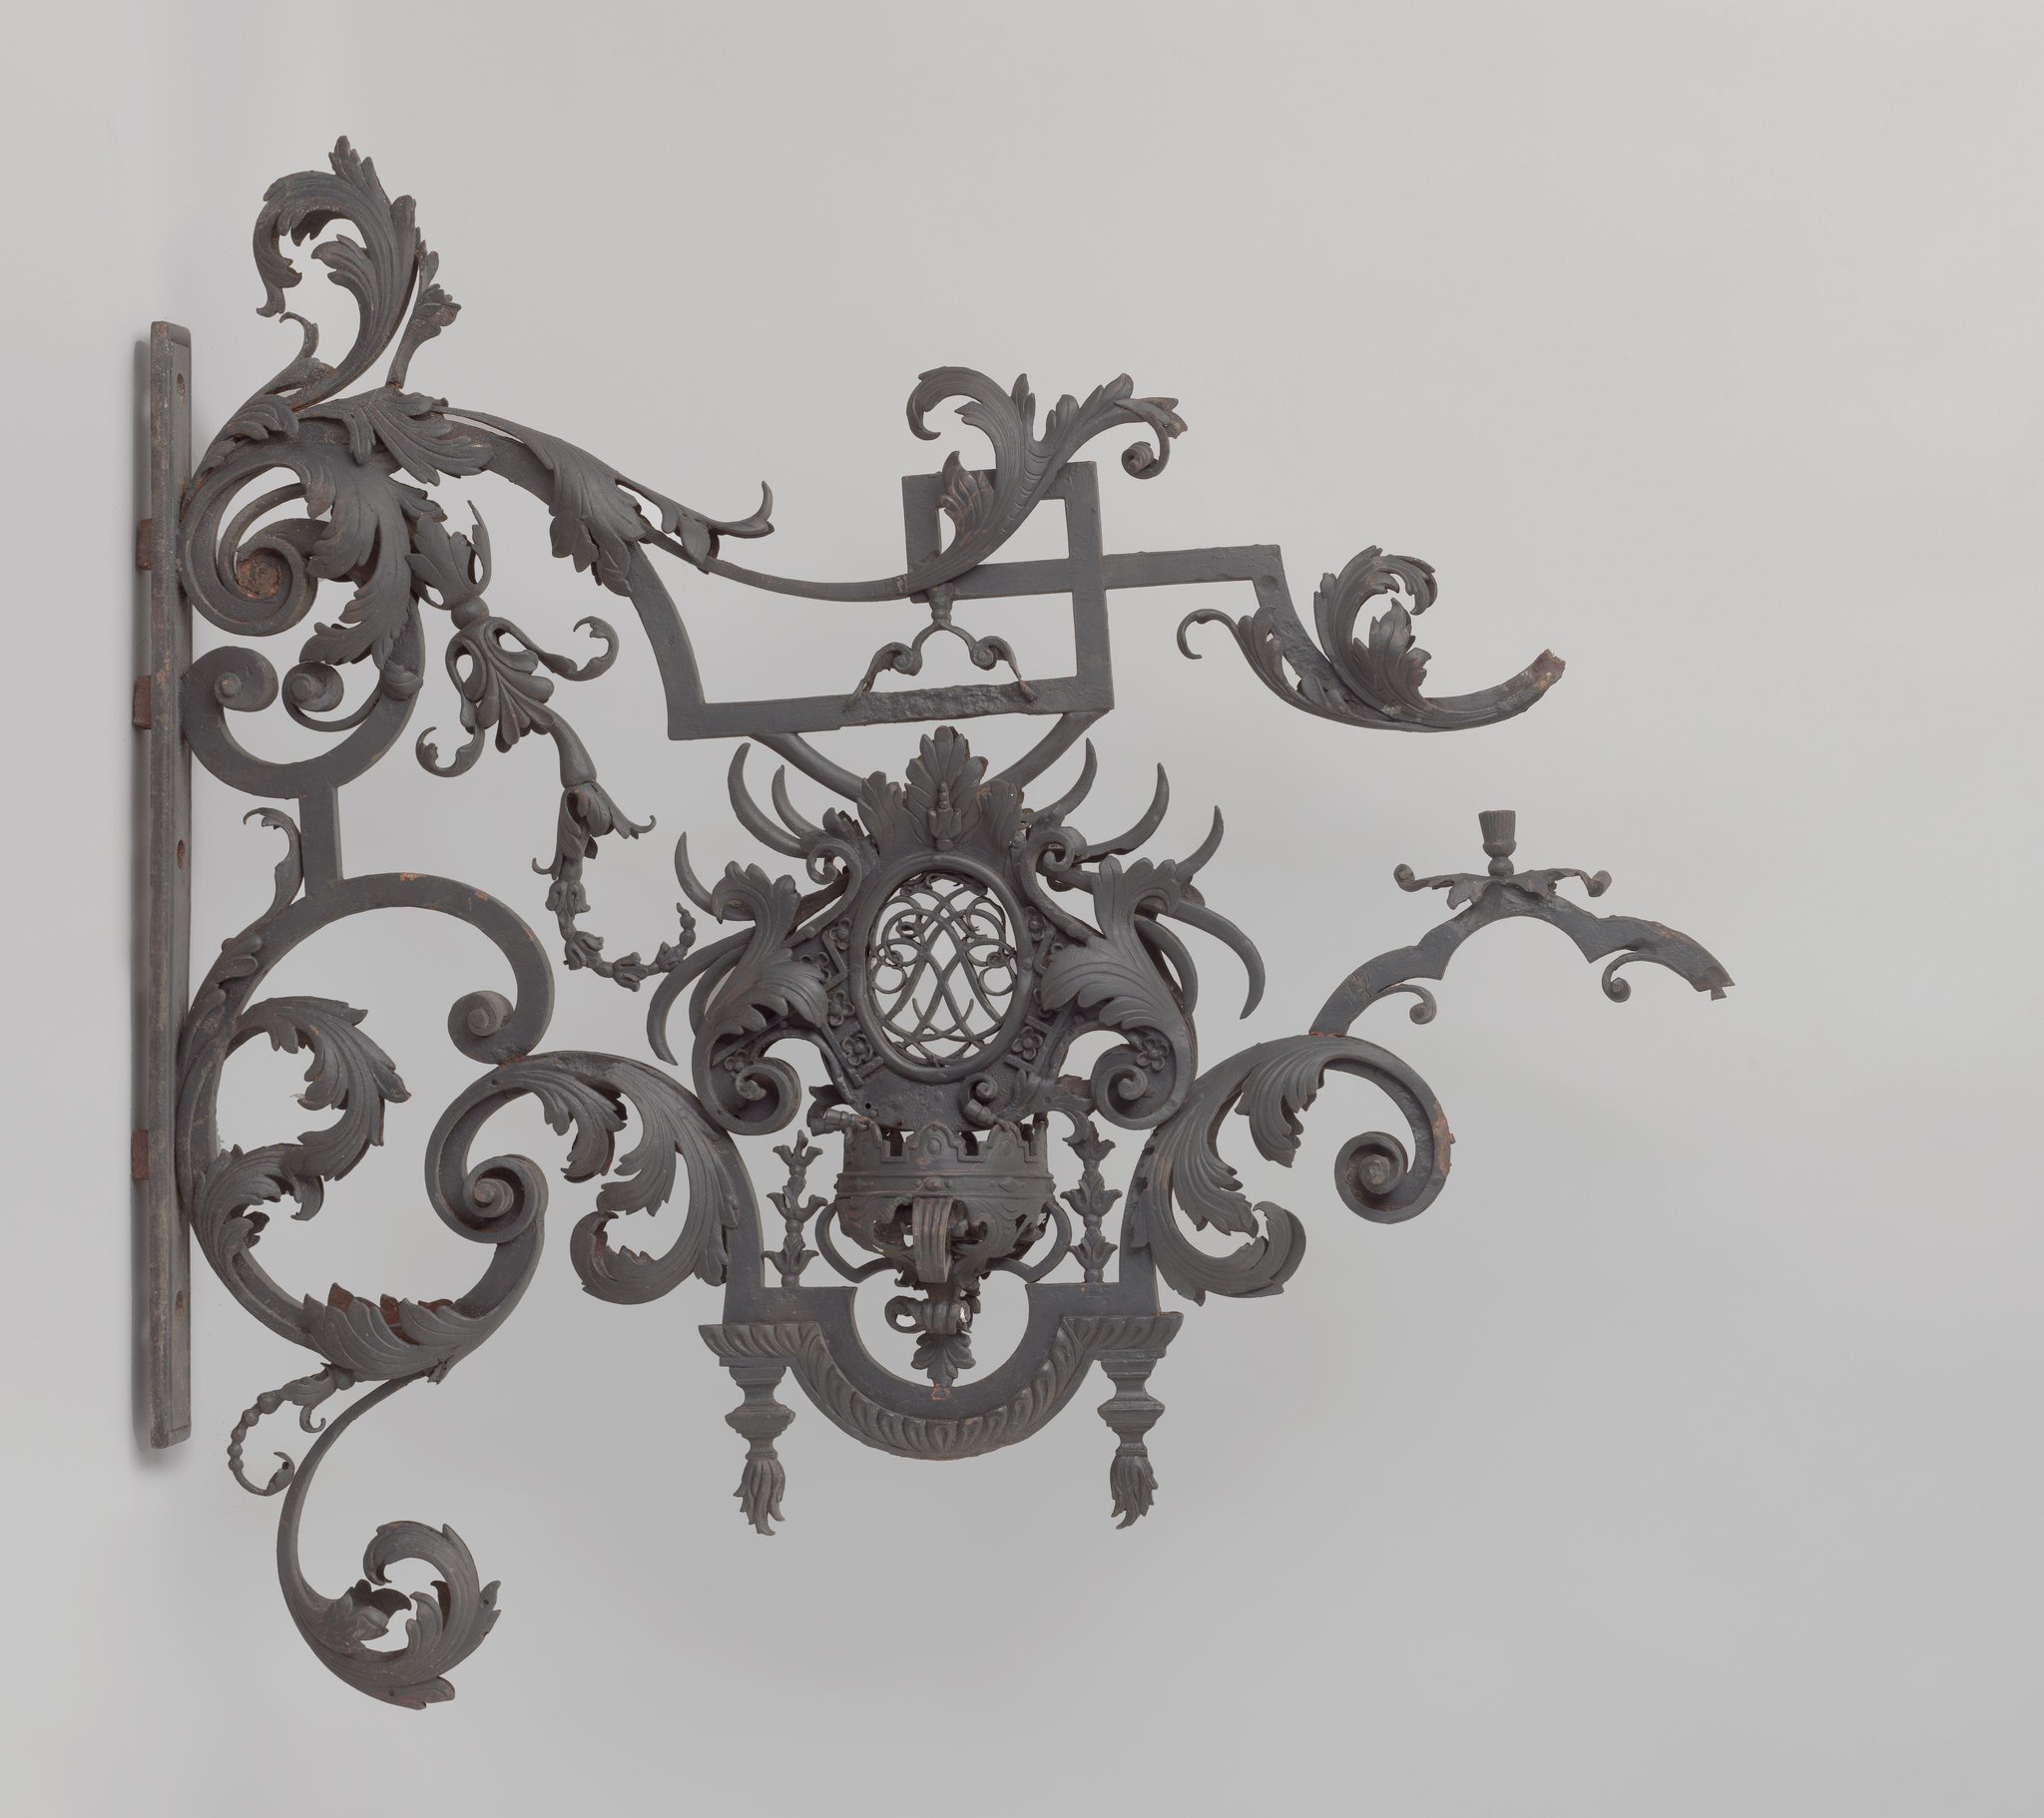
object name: uithangteken, uithangbord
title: Bekroonde cartouche met monogram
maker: Anonymous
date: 1700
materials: iron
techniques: forging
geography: amsterdam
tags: amsterdam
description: Bekroonde cartouche met monogram omgeven door acanthusbladeren. Onderdeel van een uithangteken van een smederij in de Beulingstraat te Amsterdam.